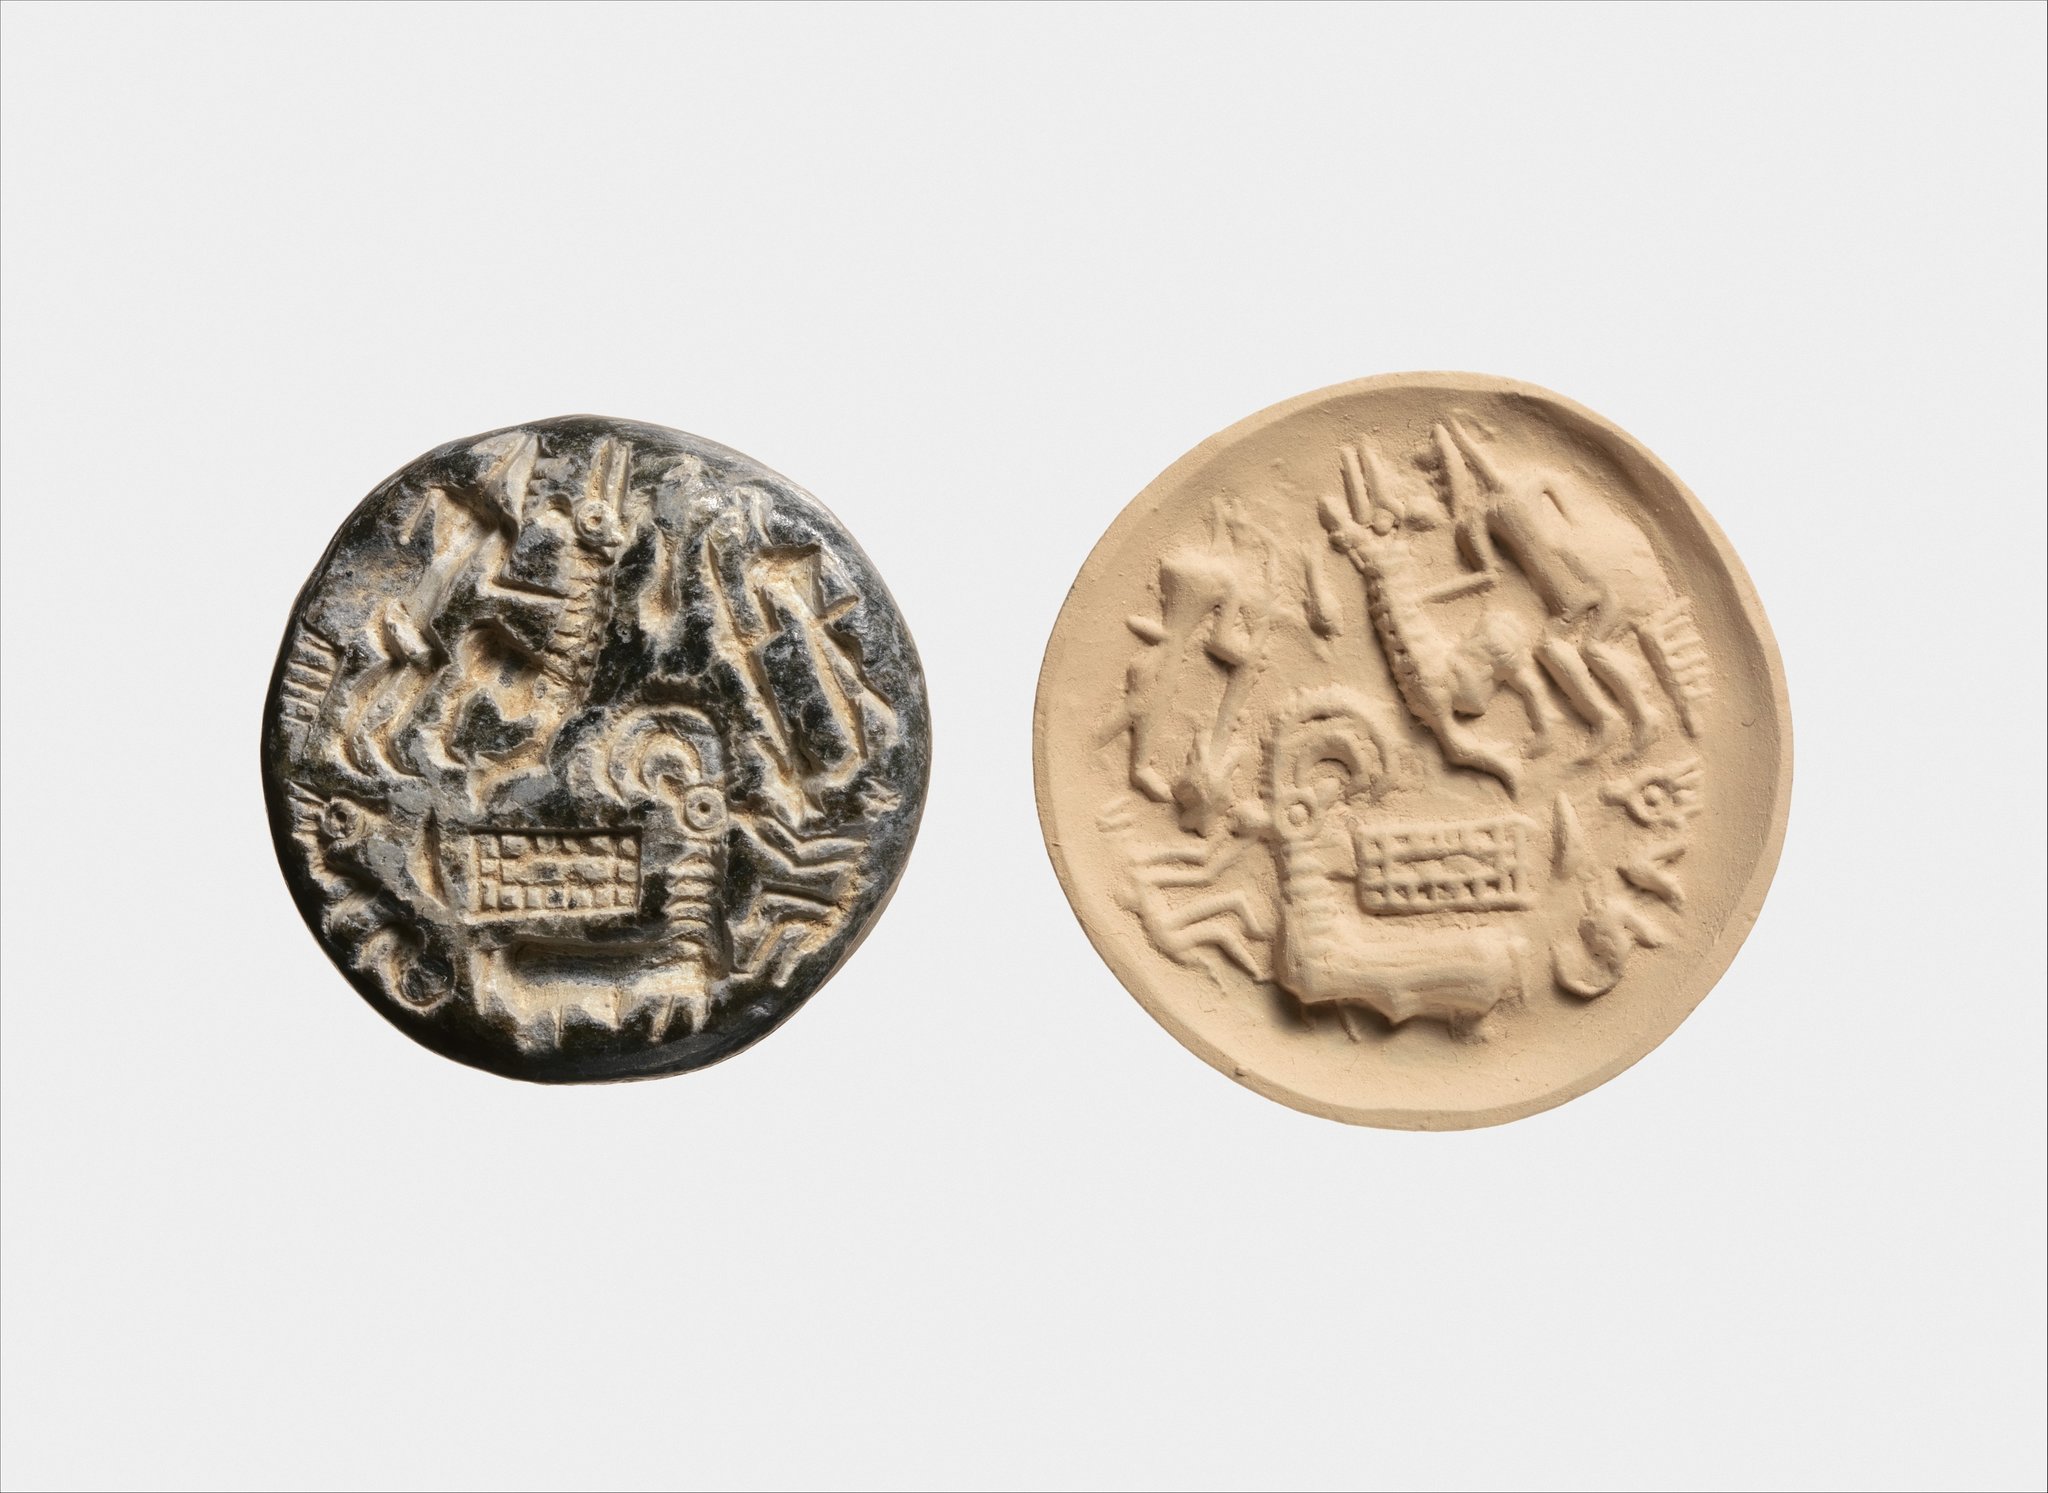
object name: stamp seal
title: Stamp seal: hunters and goats, rectangular pen (?)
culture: dilmun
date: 2000-1668 BCE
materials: mineral, stone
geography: dilmun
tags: hunting,goats